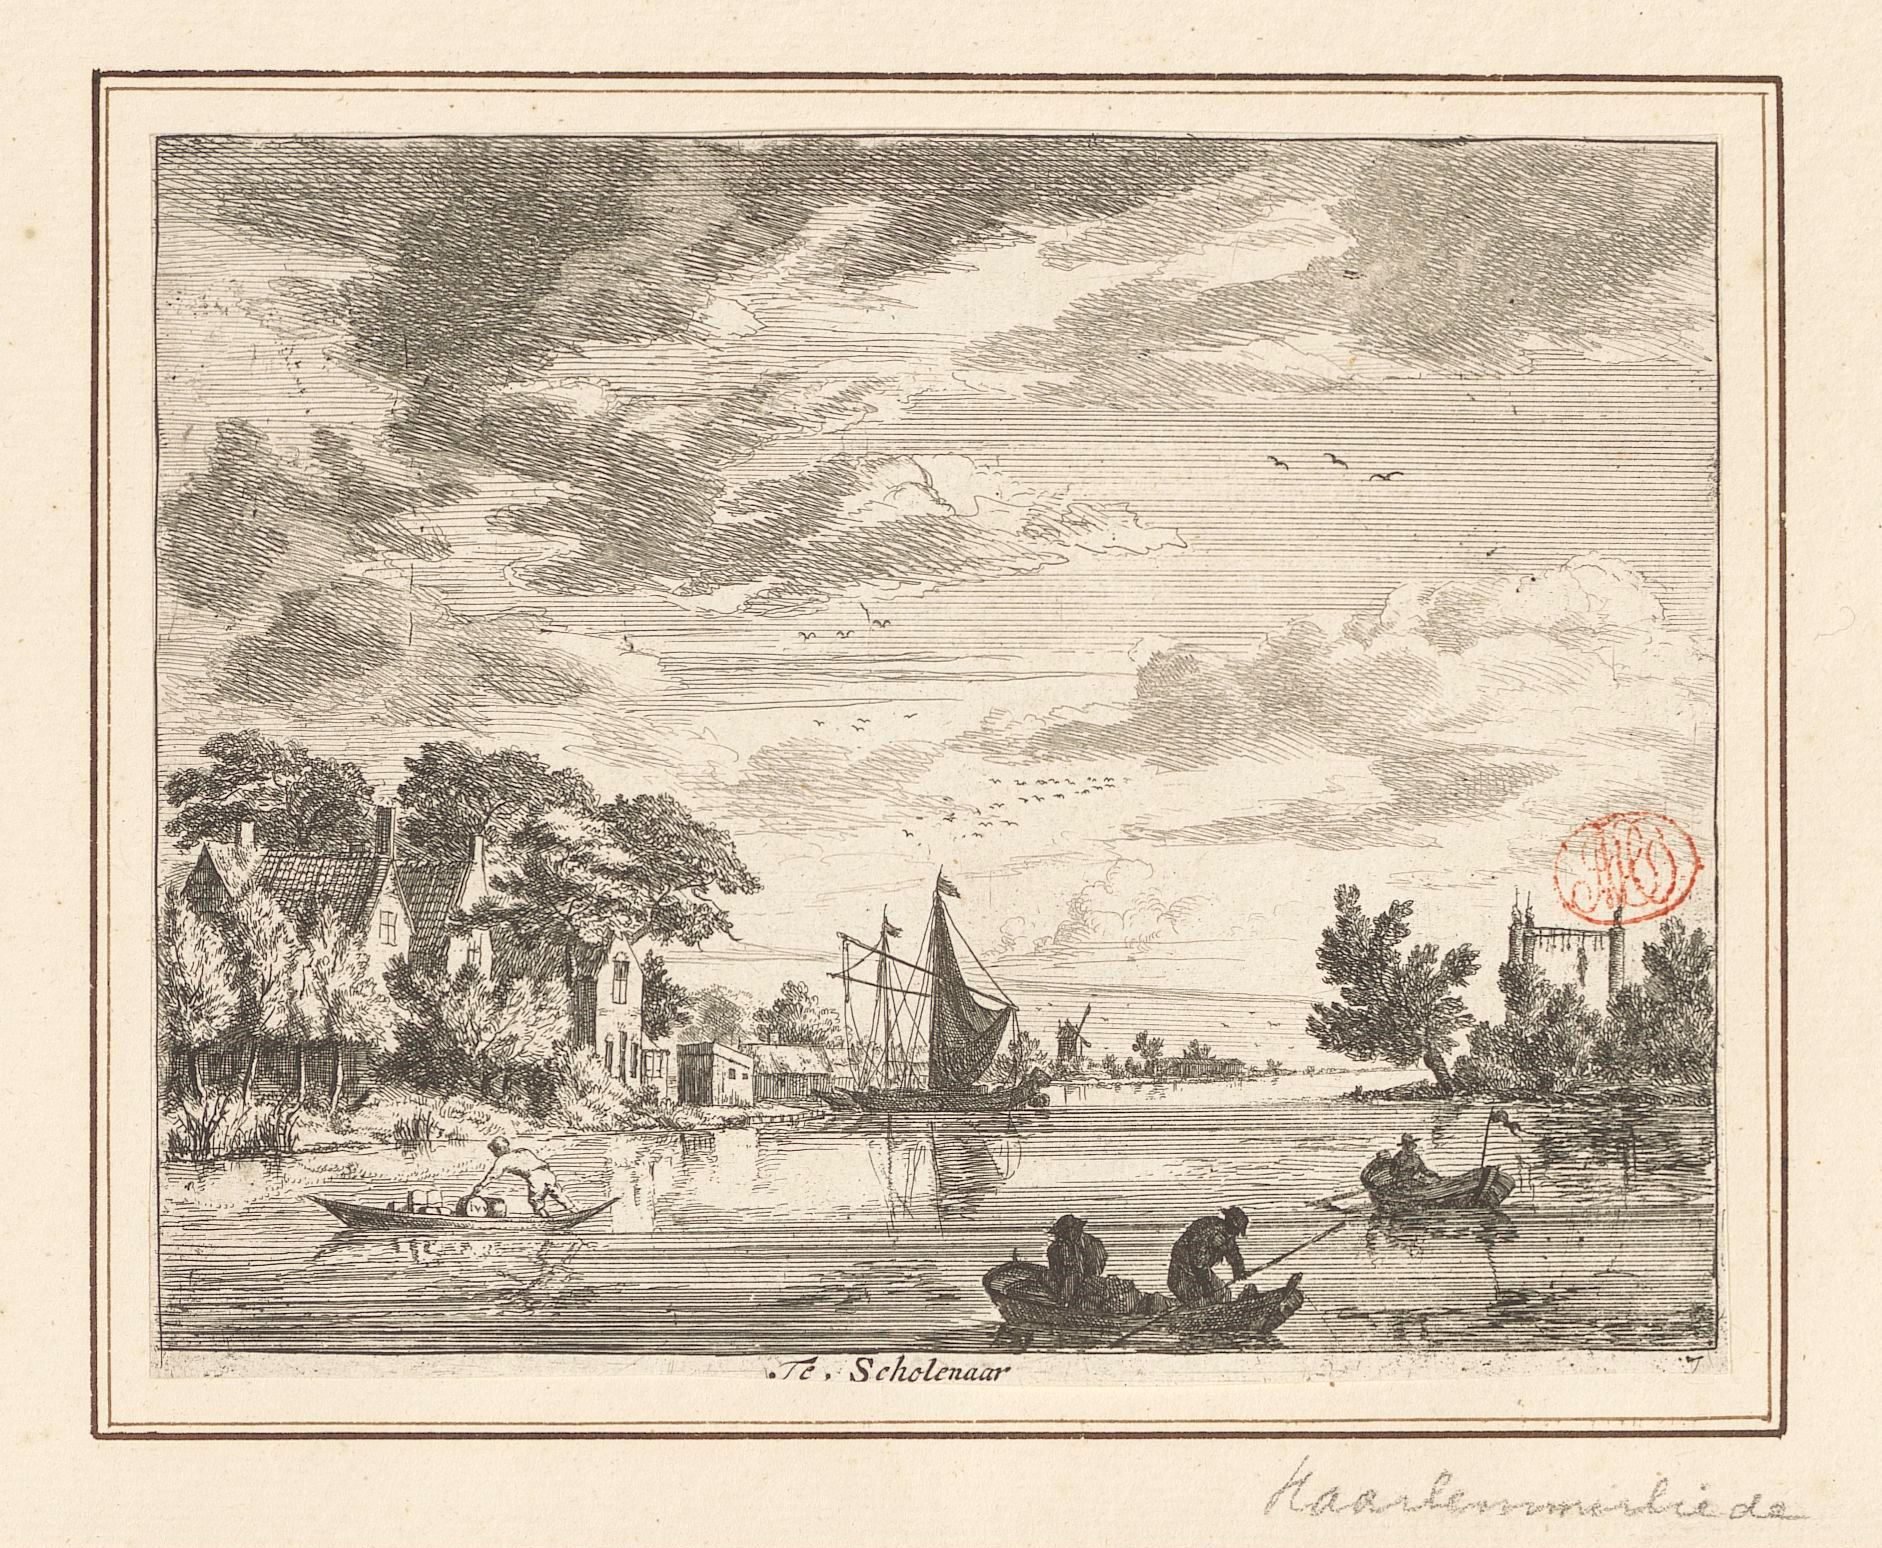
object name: print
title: Bedrijvigheid op een rivier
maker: jan vincentsz. van der vinne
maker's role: draughtsman, print maker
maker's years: 1663-1721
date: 1688-1690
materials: paper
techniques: etching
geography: haarlem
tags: instruments of torture, execution or punishment: gallows, dusk, evening twilight, sailing-ship, sailing-boat, river, rowing-boat, canoe, etc., haarlem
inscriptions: collector's mark: Lugt 195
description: Drie roeiboten en een zeilschip op een rivier bij een vallende avond. Rechts een galgenveld. Rechtsonder genummerd: 7.